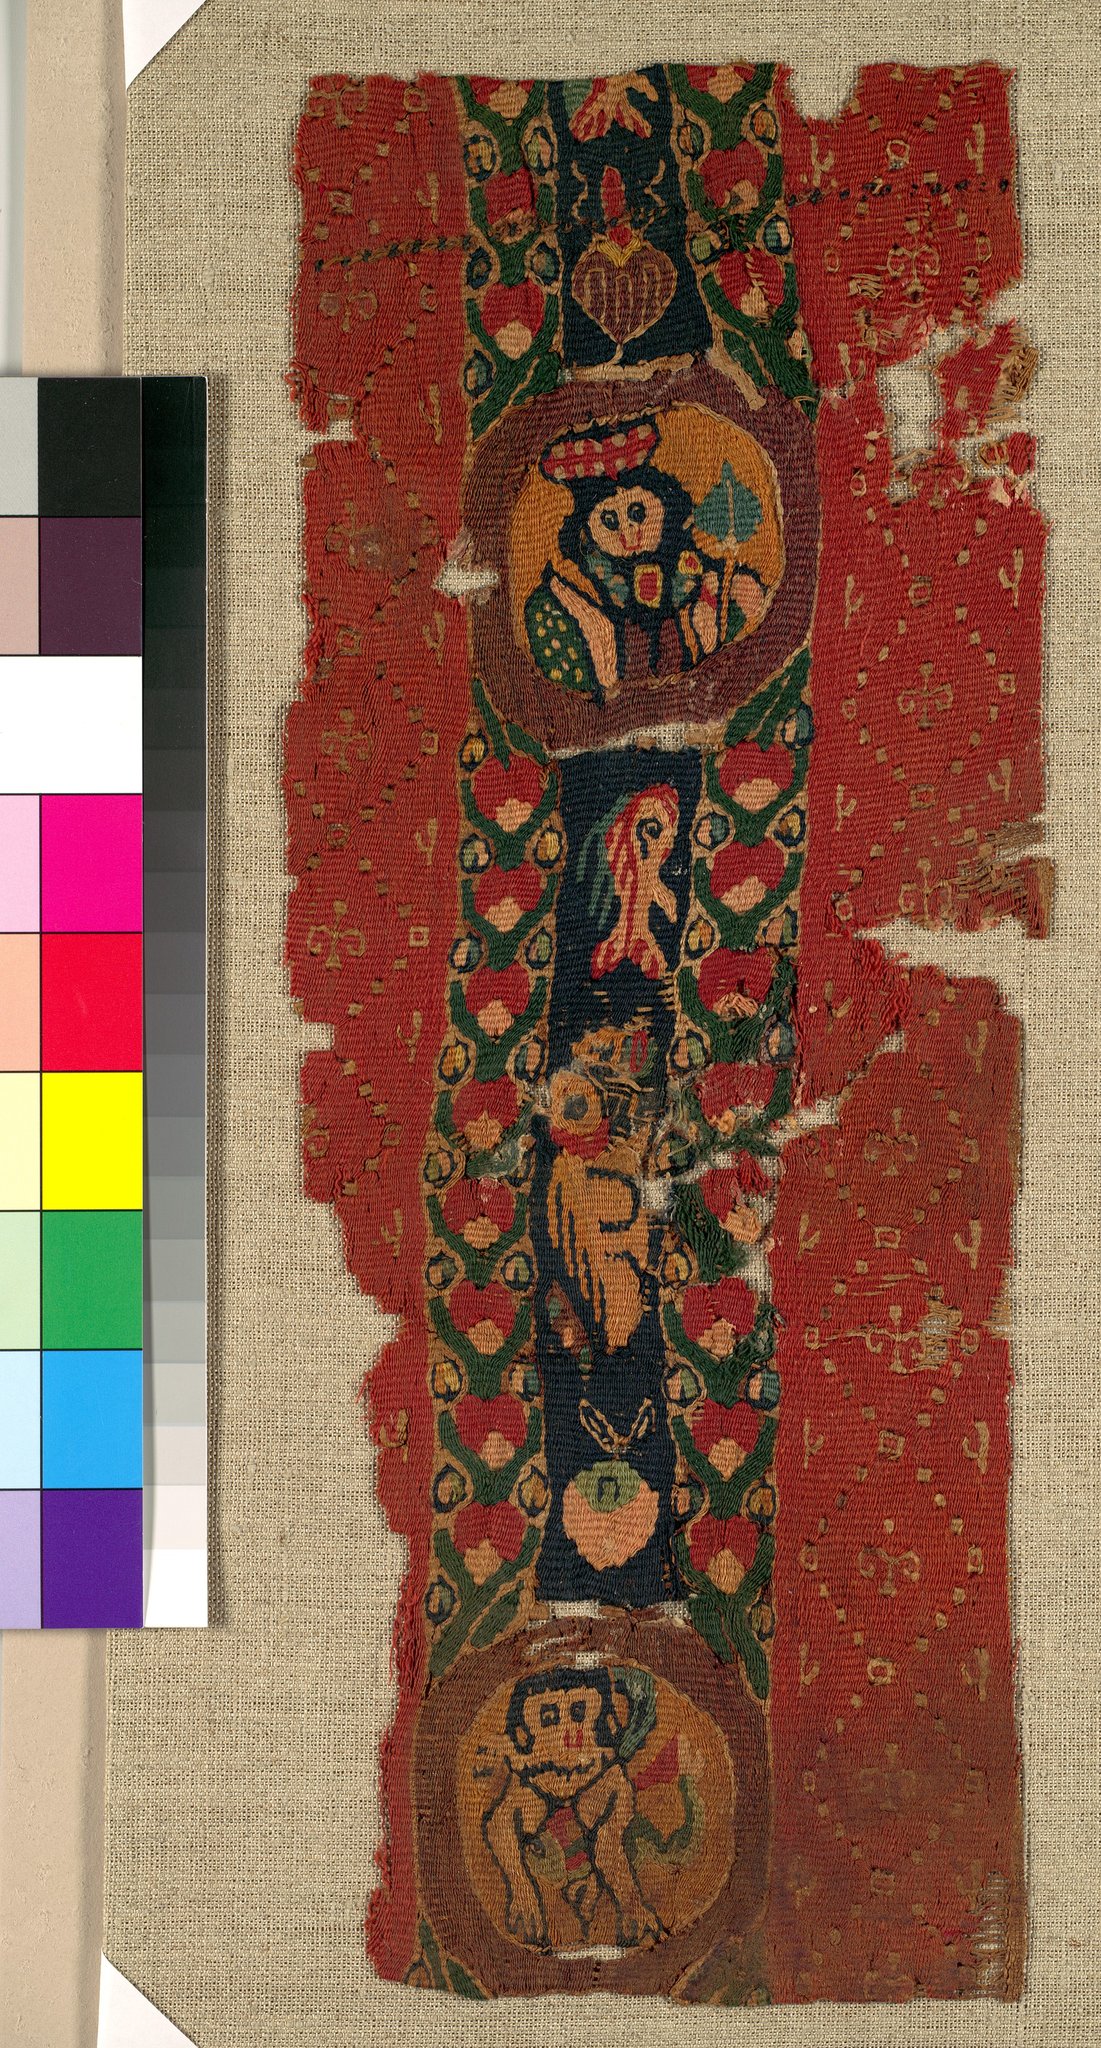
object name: textile fragment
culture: byzantine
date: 501-800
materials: linen, wool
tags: fish,monkeys